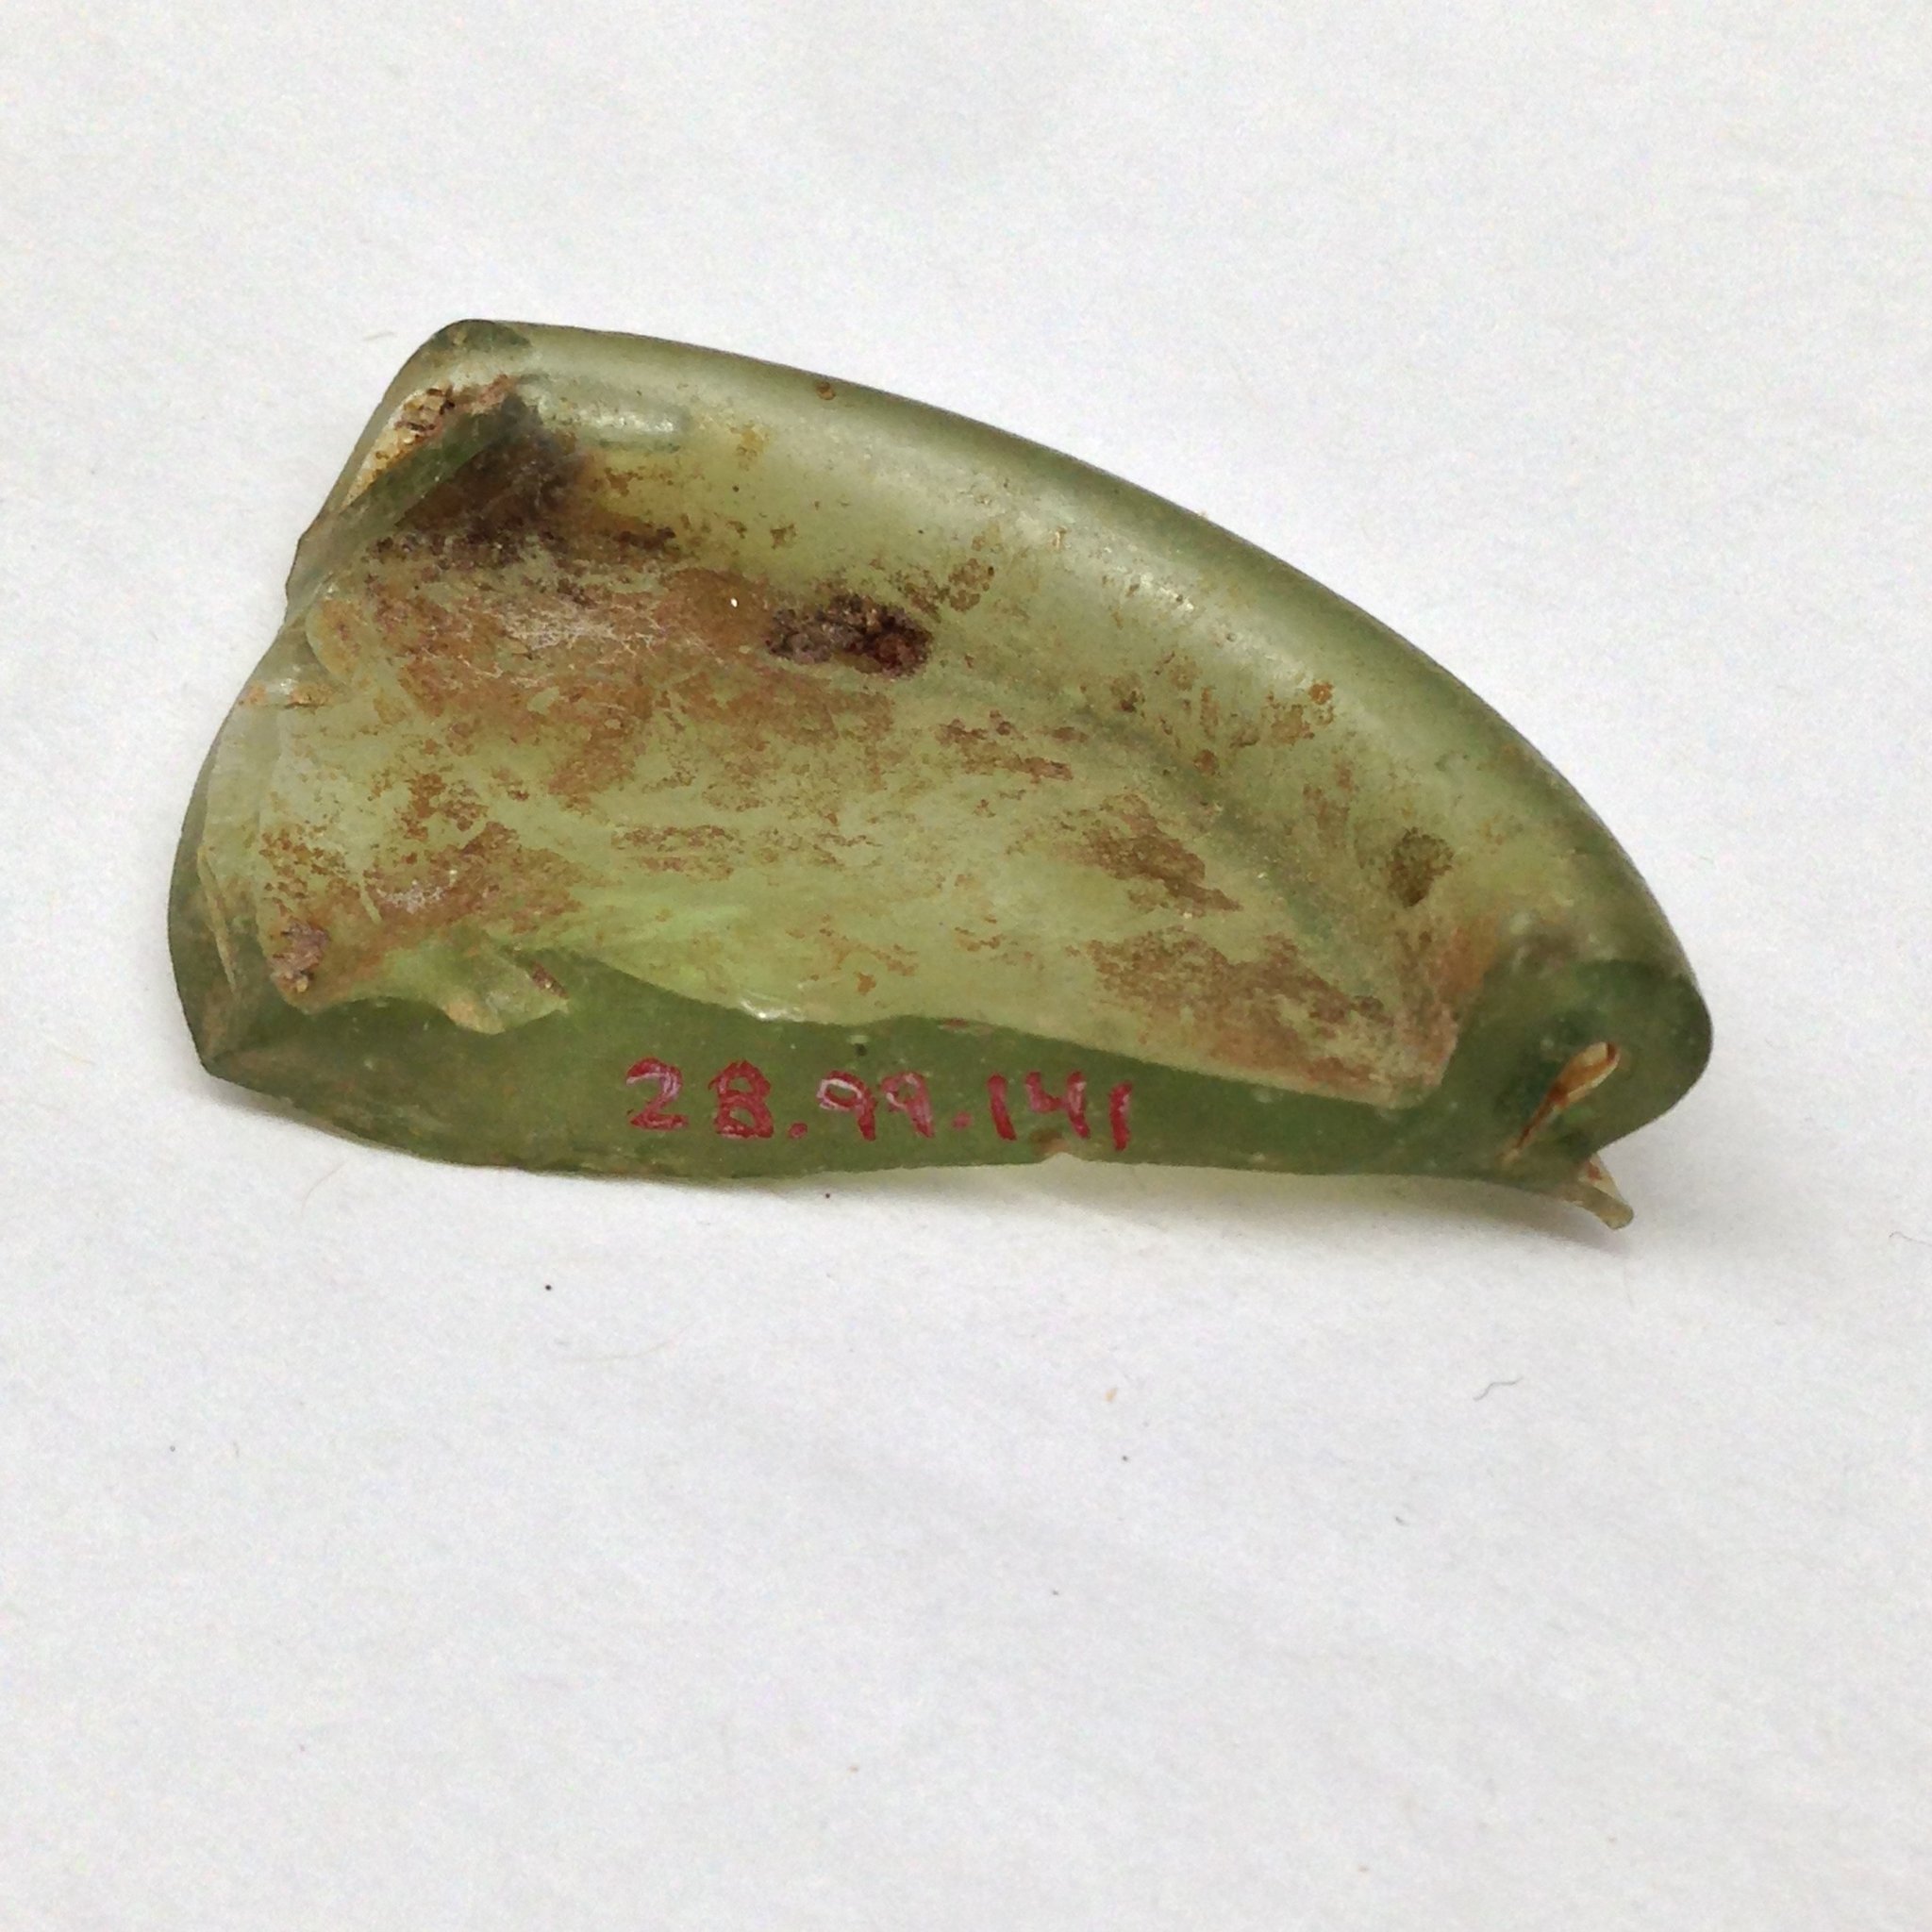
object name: fragment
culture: european or middle eastern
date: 1150-1250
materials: ceramic, glass